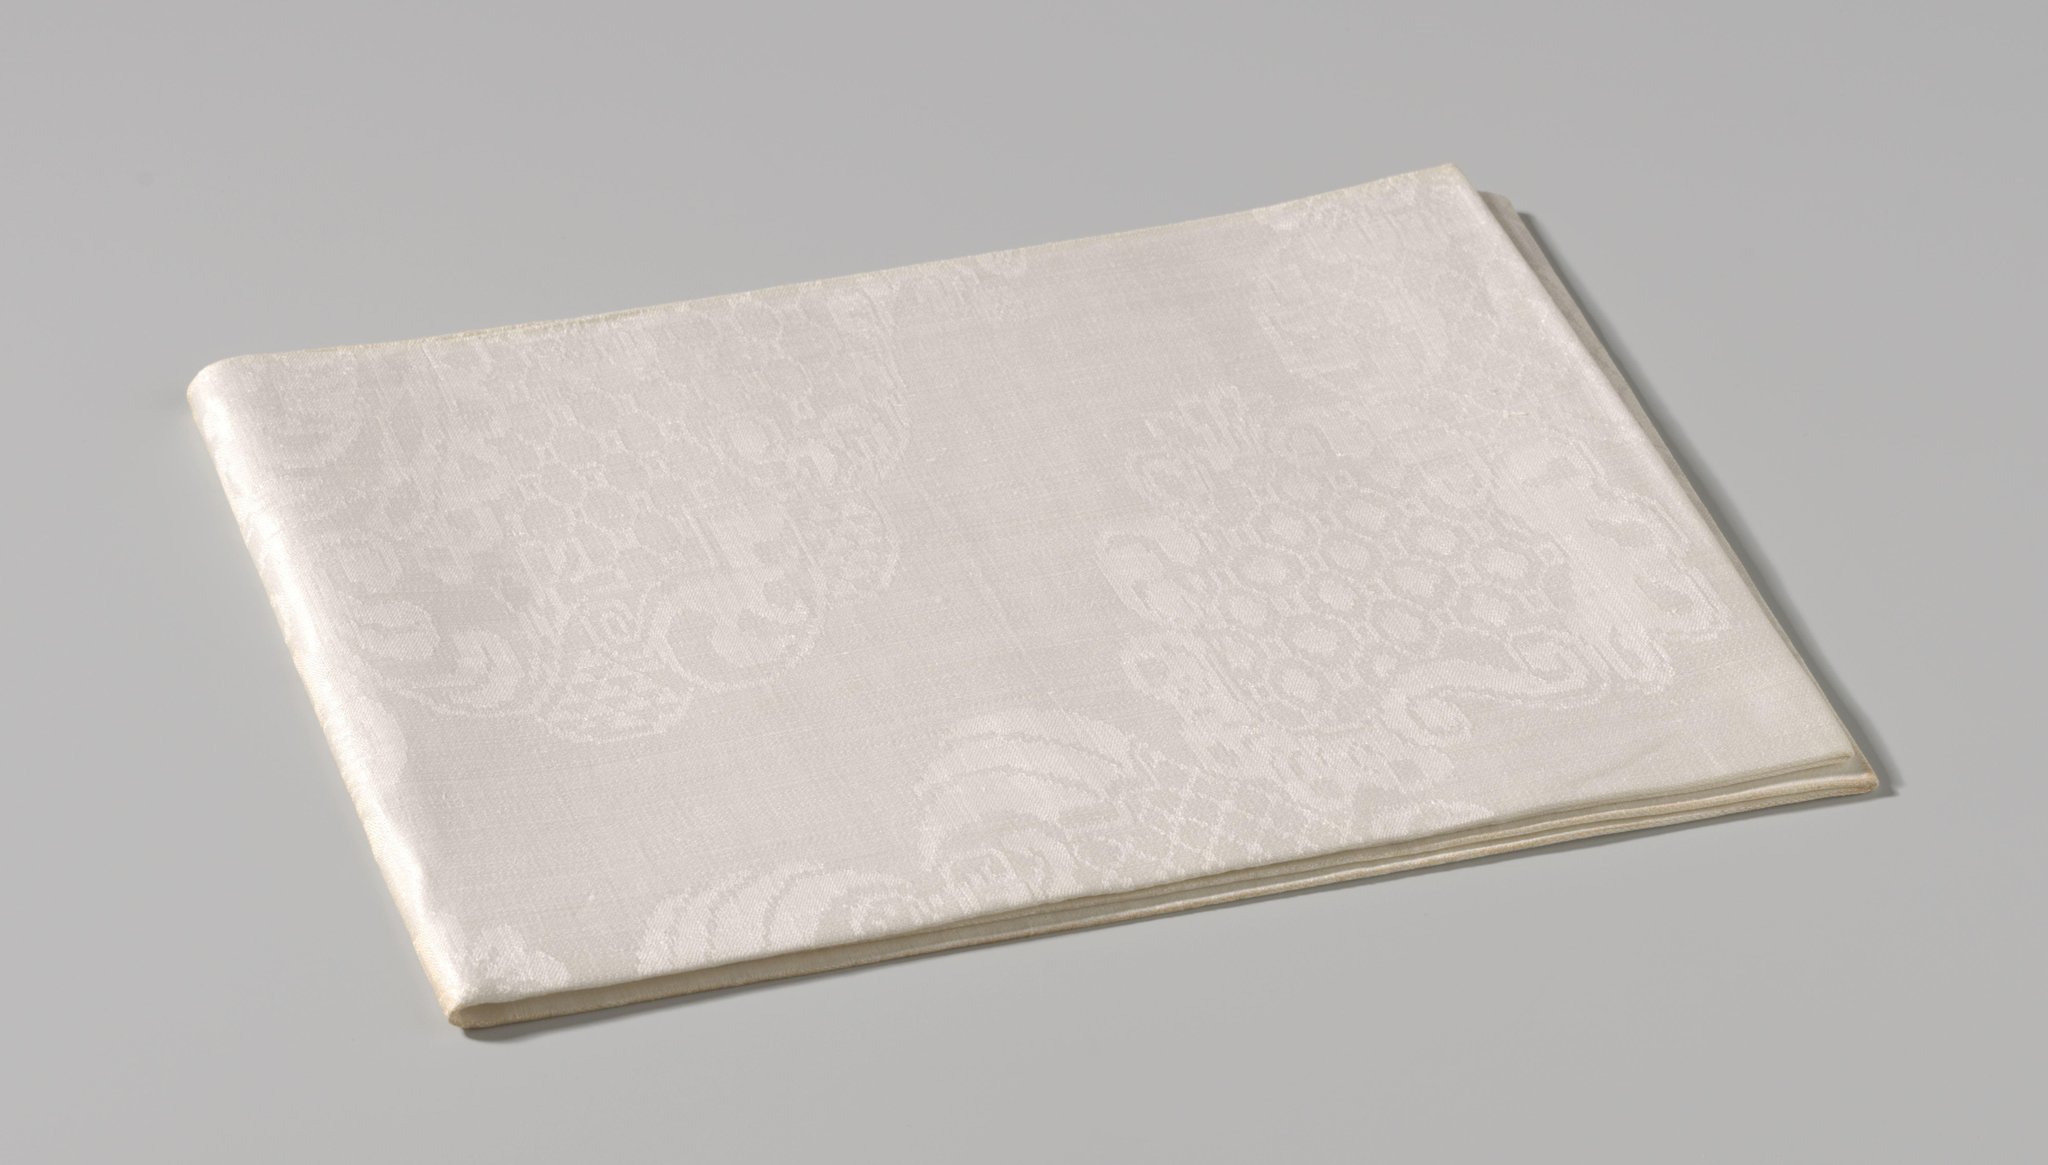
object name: napkin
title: Servet van wit linnendamast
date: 1764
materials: linen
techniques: damask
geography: northern netherlands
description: Wit linnendamasten servet met z.g. kantpatroon, merk kroon G 12